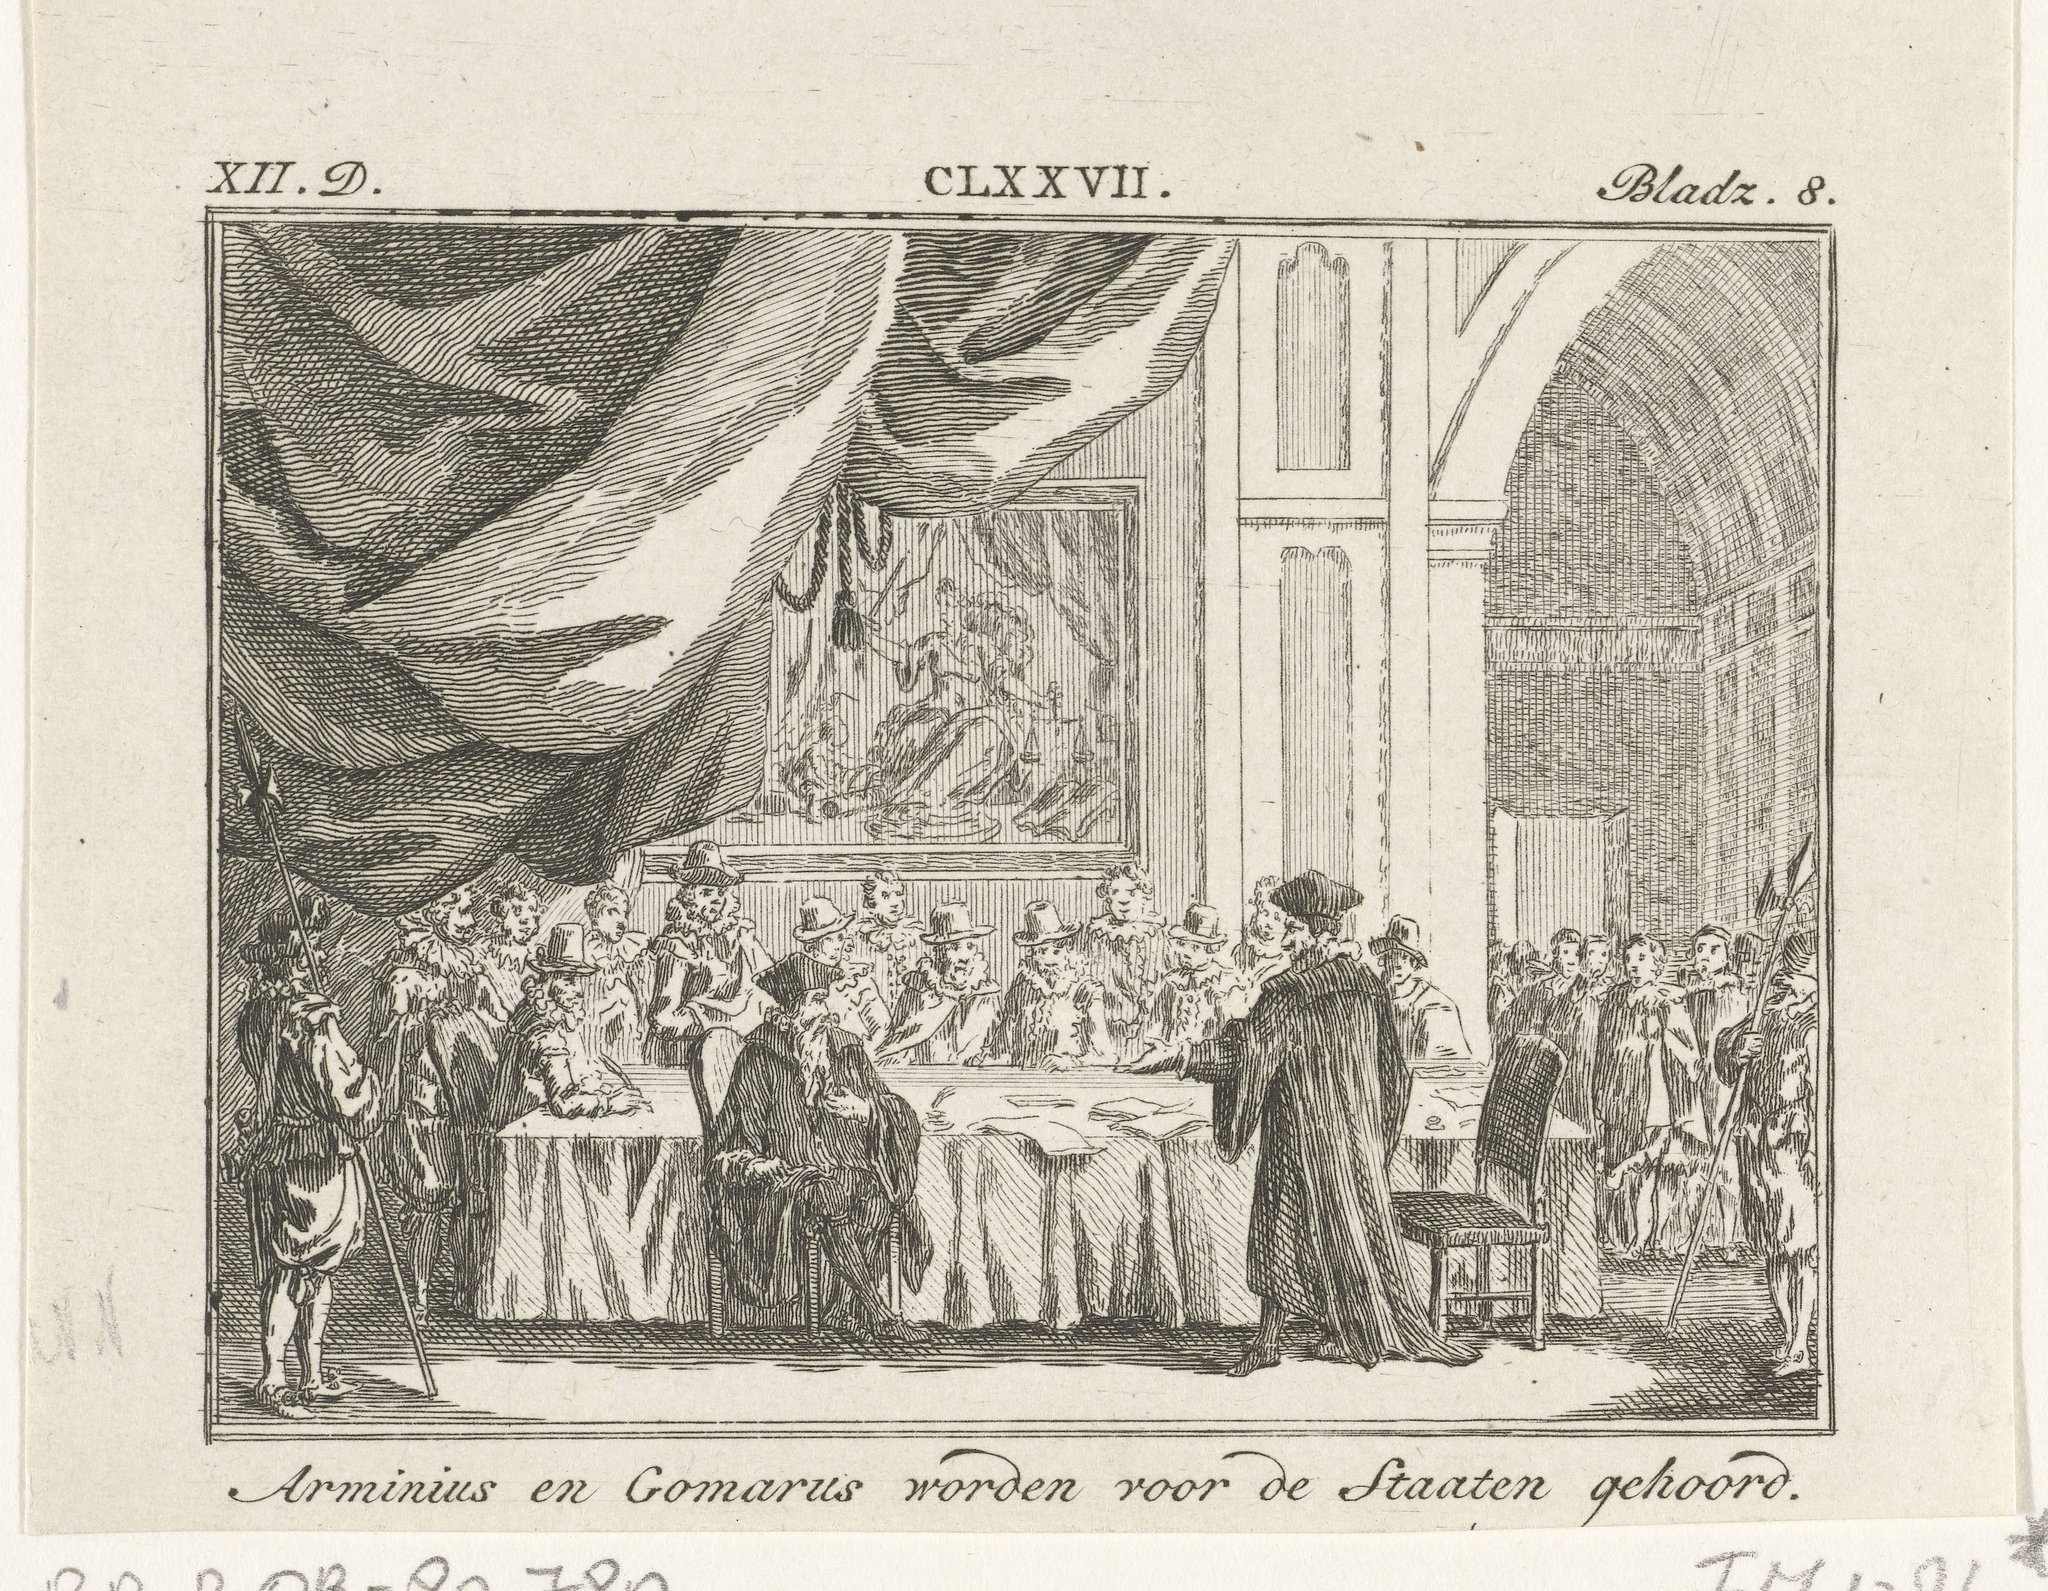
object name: history print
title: Arminius en Gomarus worden voor de Staaten gehoord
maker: simon fokke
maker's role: draughtsman, print maker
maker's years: 1712-1784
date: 1722-1784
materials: paper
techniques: etching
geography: northern netherlands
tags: leiden, organizations, assemblies, etc. in protestant churches, negotiations, conference ~ diplomacy, the hague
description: Illustratie uit een onbekend werk, dl. XII, p. 8, nr. CLXXVII. Niet in Frederik Muller; door het RPK toegevoegd nummer. De voorstelling voorheen onjuist geïdentificeerd als 'De Haagse conferentie waarbij Arminius en Gomarus door de Staten worden gehoord, 1611'. Arminius was echter al in 1609 overleden.